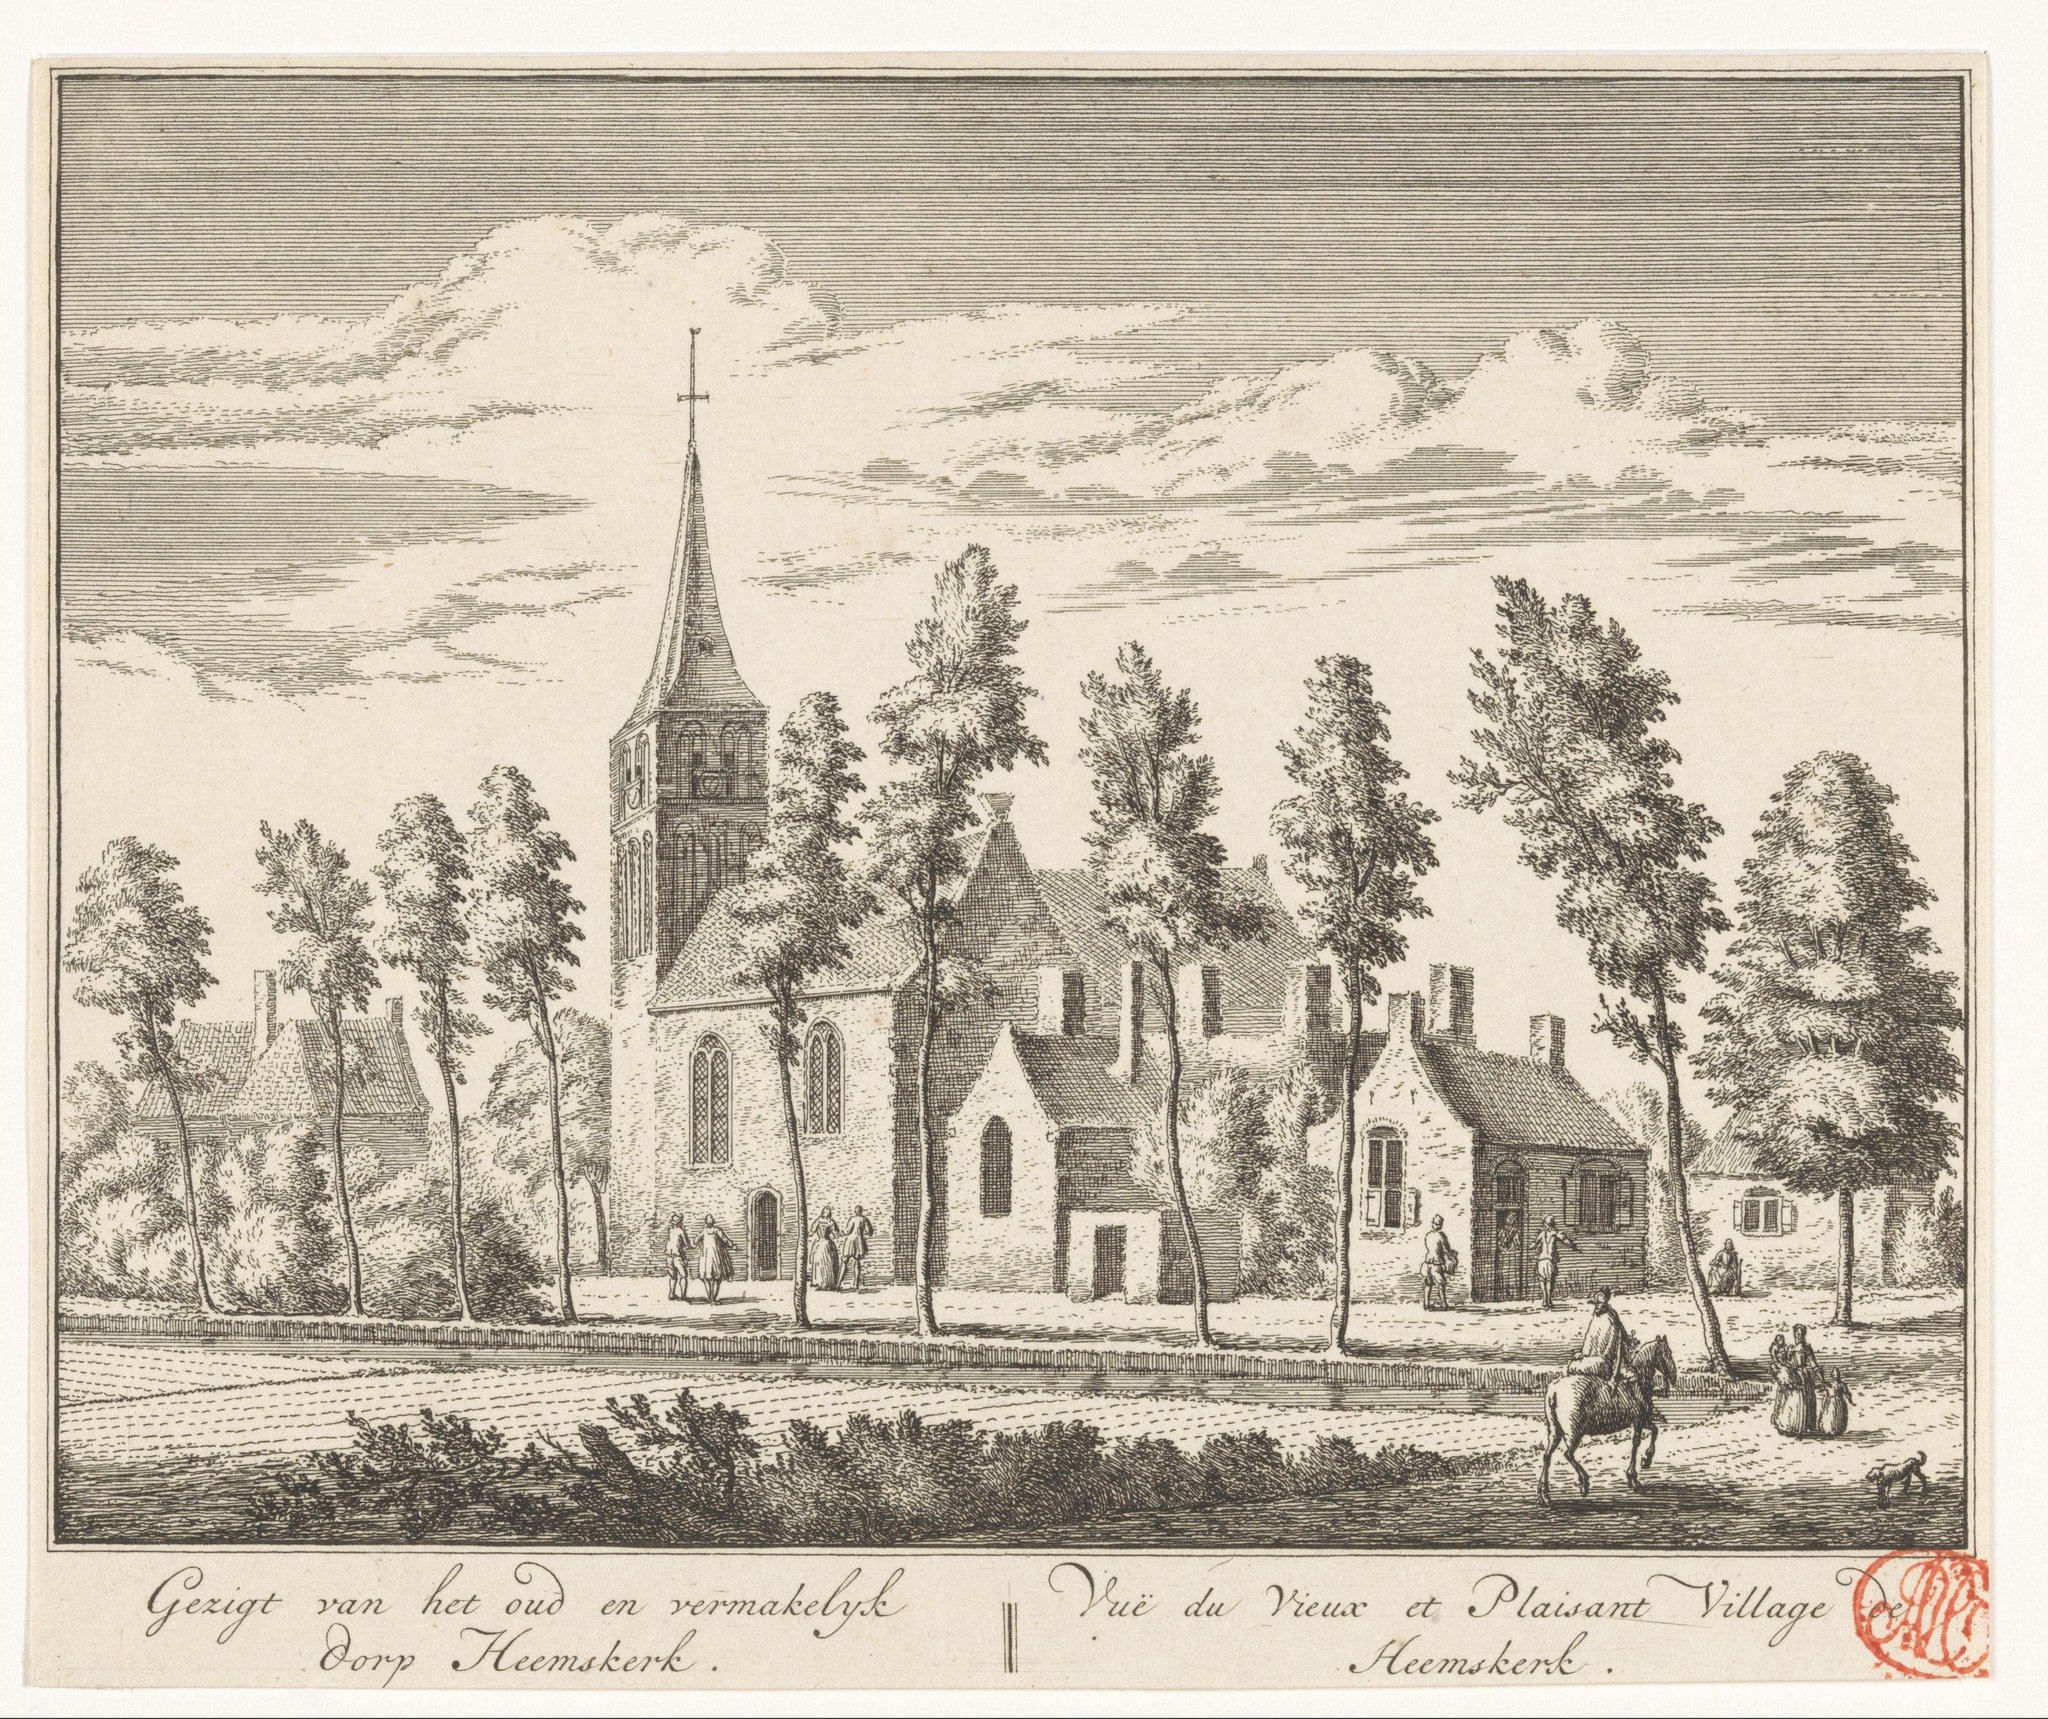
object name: book illustration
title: Gezicht op Heemskerk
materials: paper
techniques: etching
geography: amsterdam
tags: prospect of village, silhouette of village, church (exterior), public road in village (+ city(-scape) with figures, staffage)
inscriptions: collector's mark: Lugt 195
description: Prent ook gebruikt in: Rademaker, Abraham. Hollands Tempe verherelykt, vertoond in dertig uitmuntende gezigten; beginnende van Amsterdam (…) / La Hollande et tout son eclat et beauté, remontrée par trente exellentes vues, commençant d'Amsterdam (…). Amsterdam: Leonard Schenk, 1728.